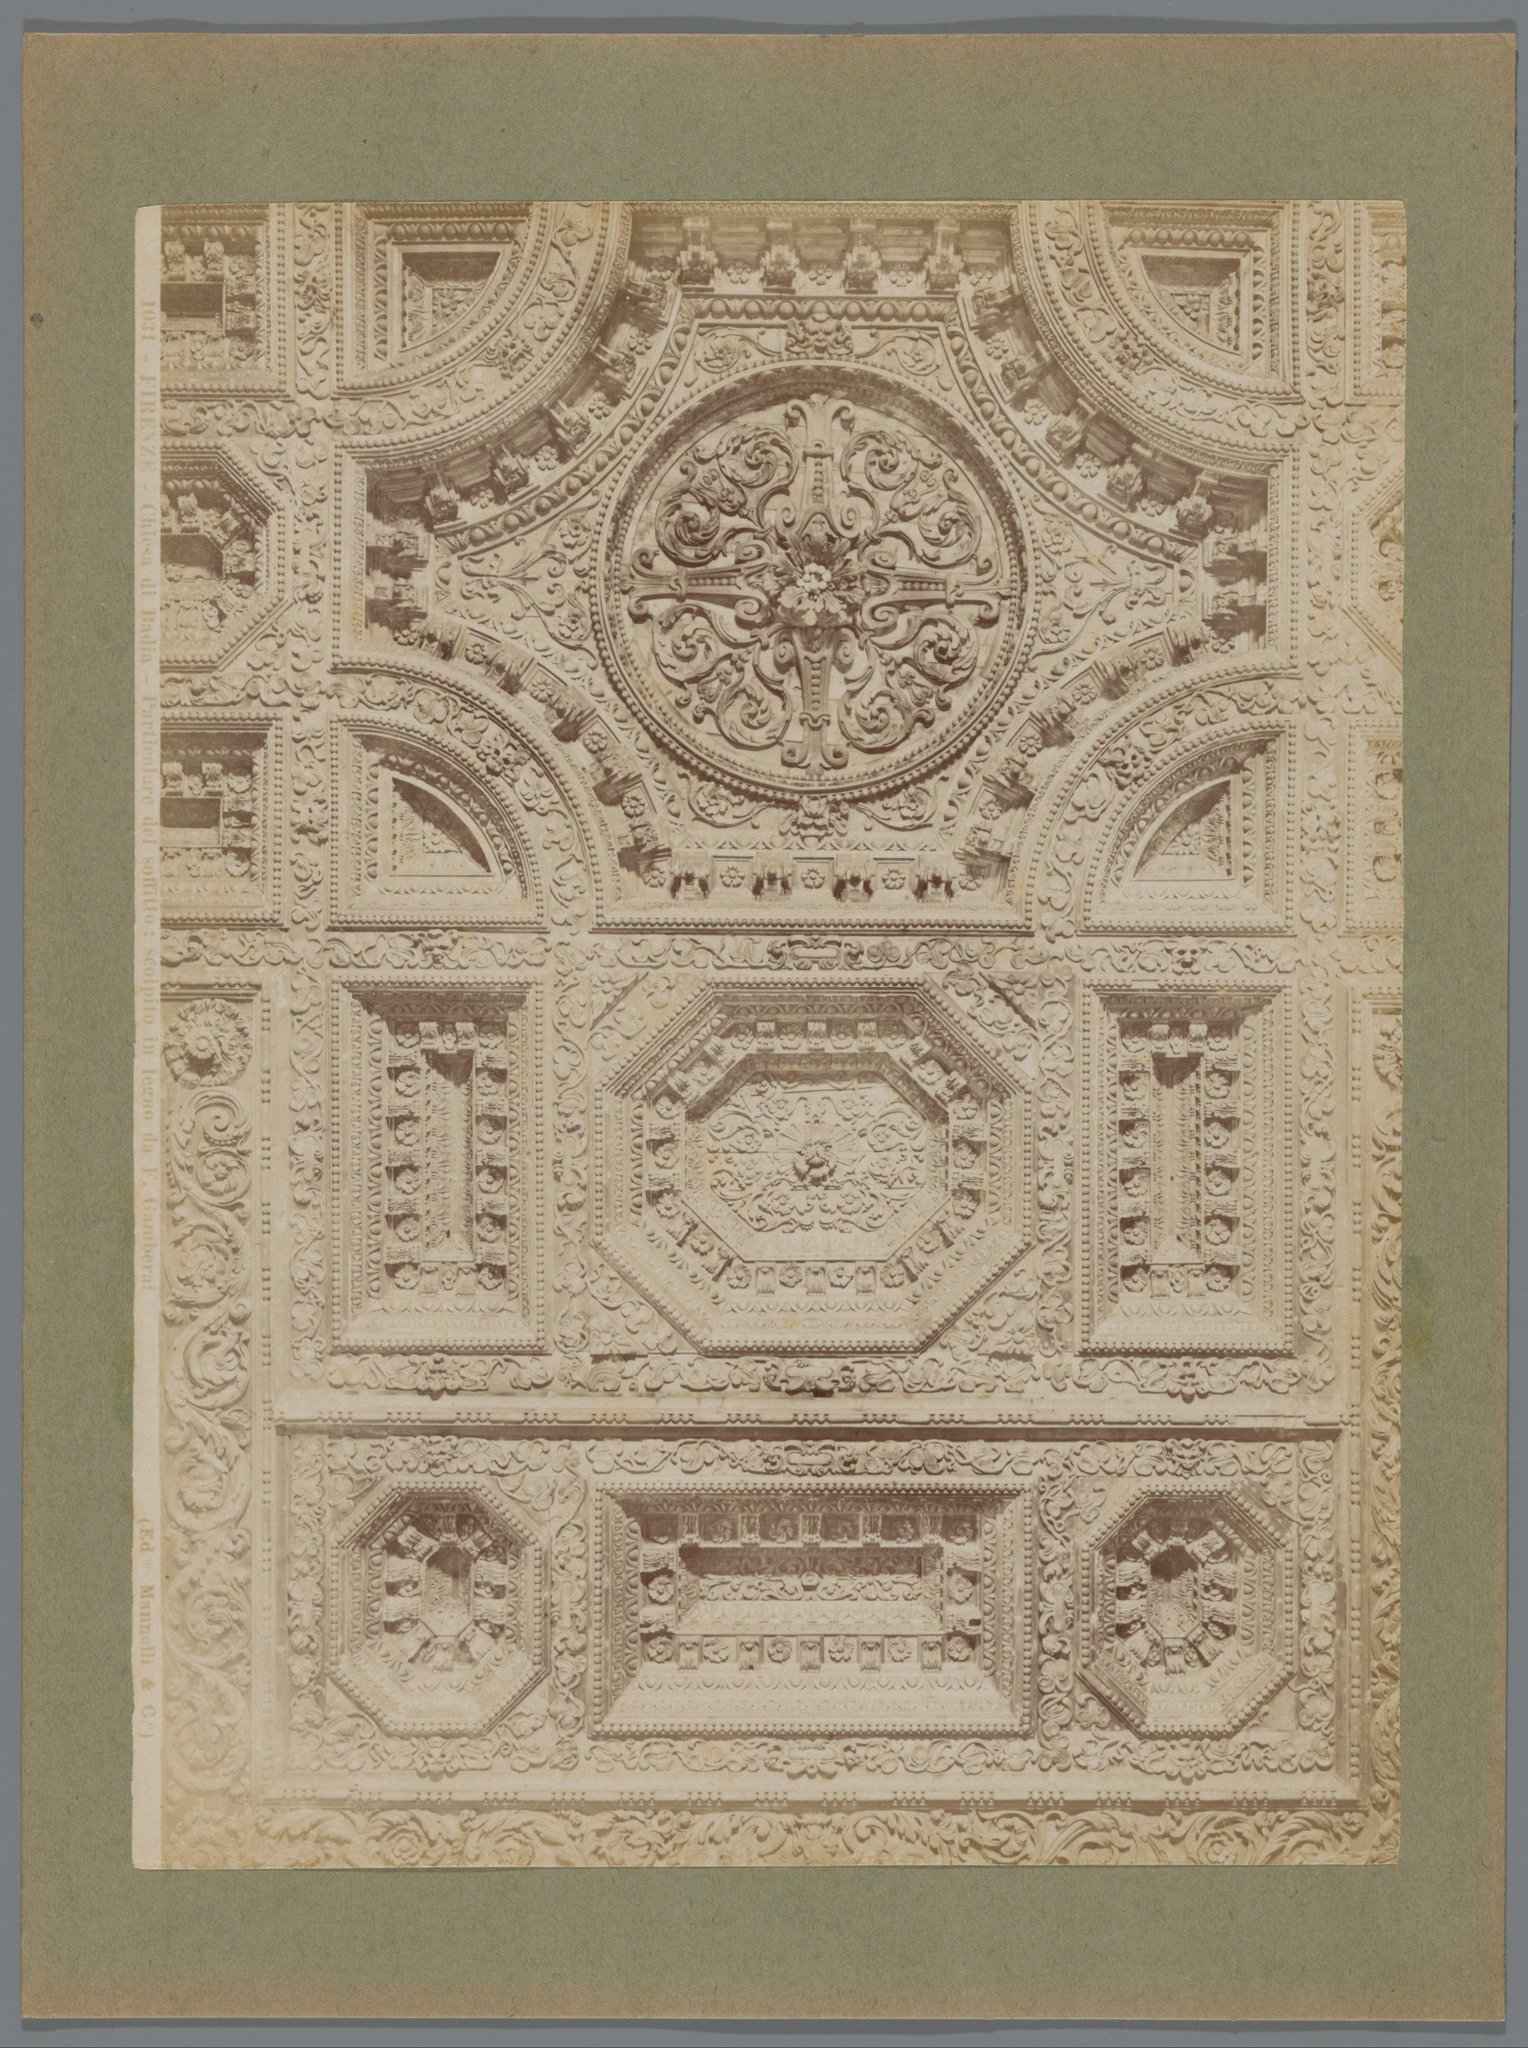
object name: photograph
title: Detail van het houten plafond in de Badia Fiorentina te Florence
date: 1851-1900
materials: cardboard, paper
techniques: albumen print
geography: florence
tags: carving ~ applied arts, (decorated) ceiling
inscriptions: number: ‘1031’